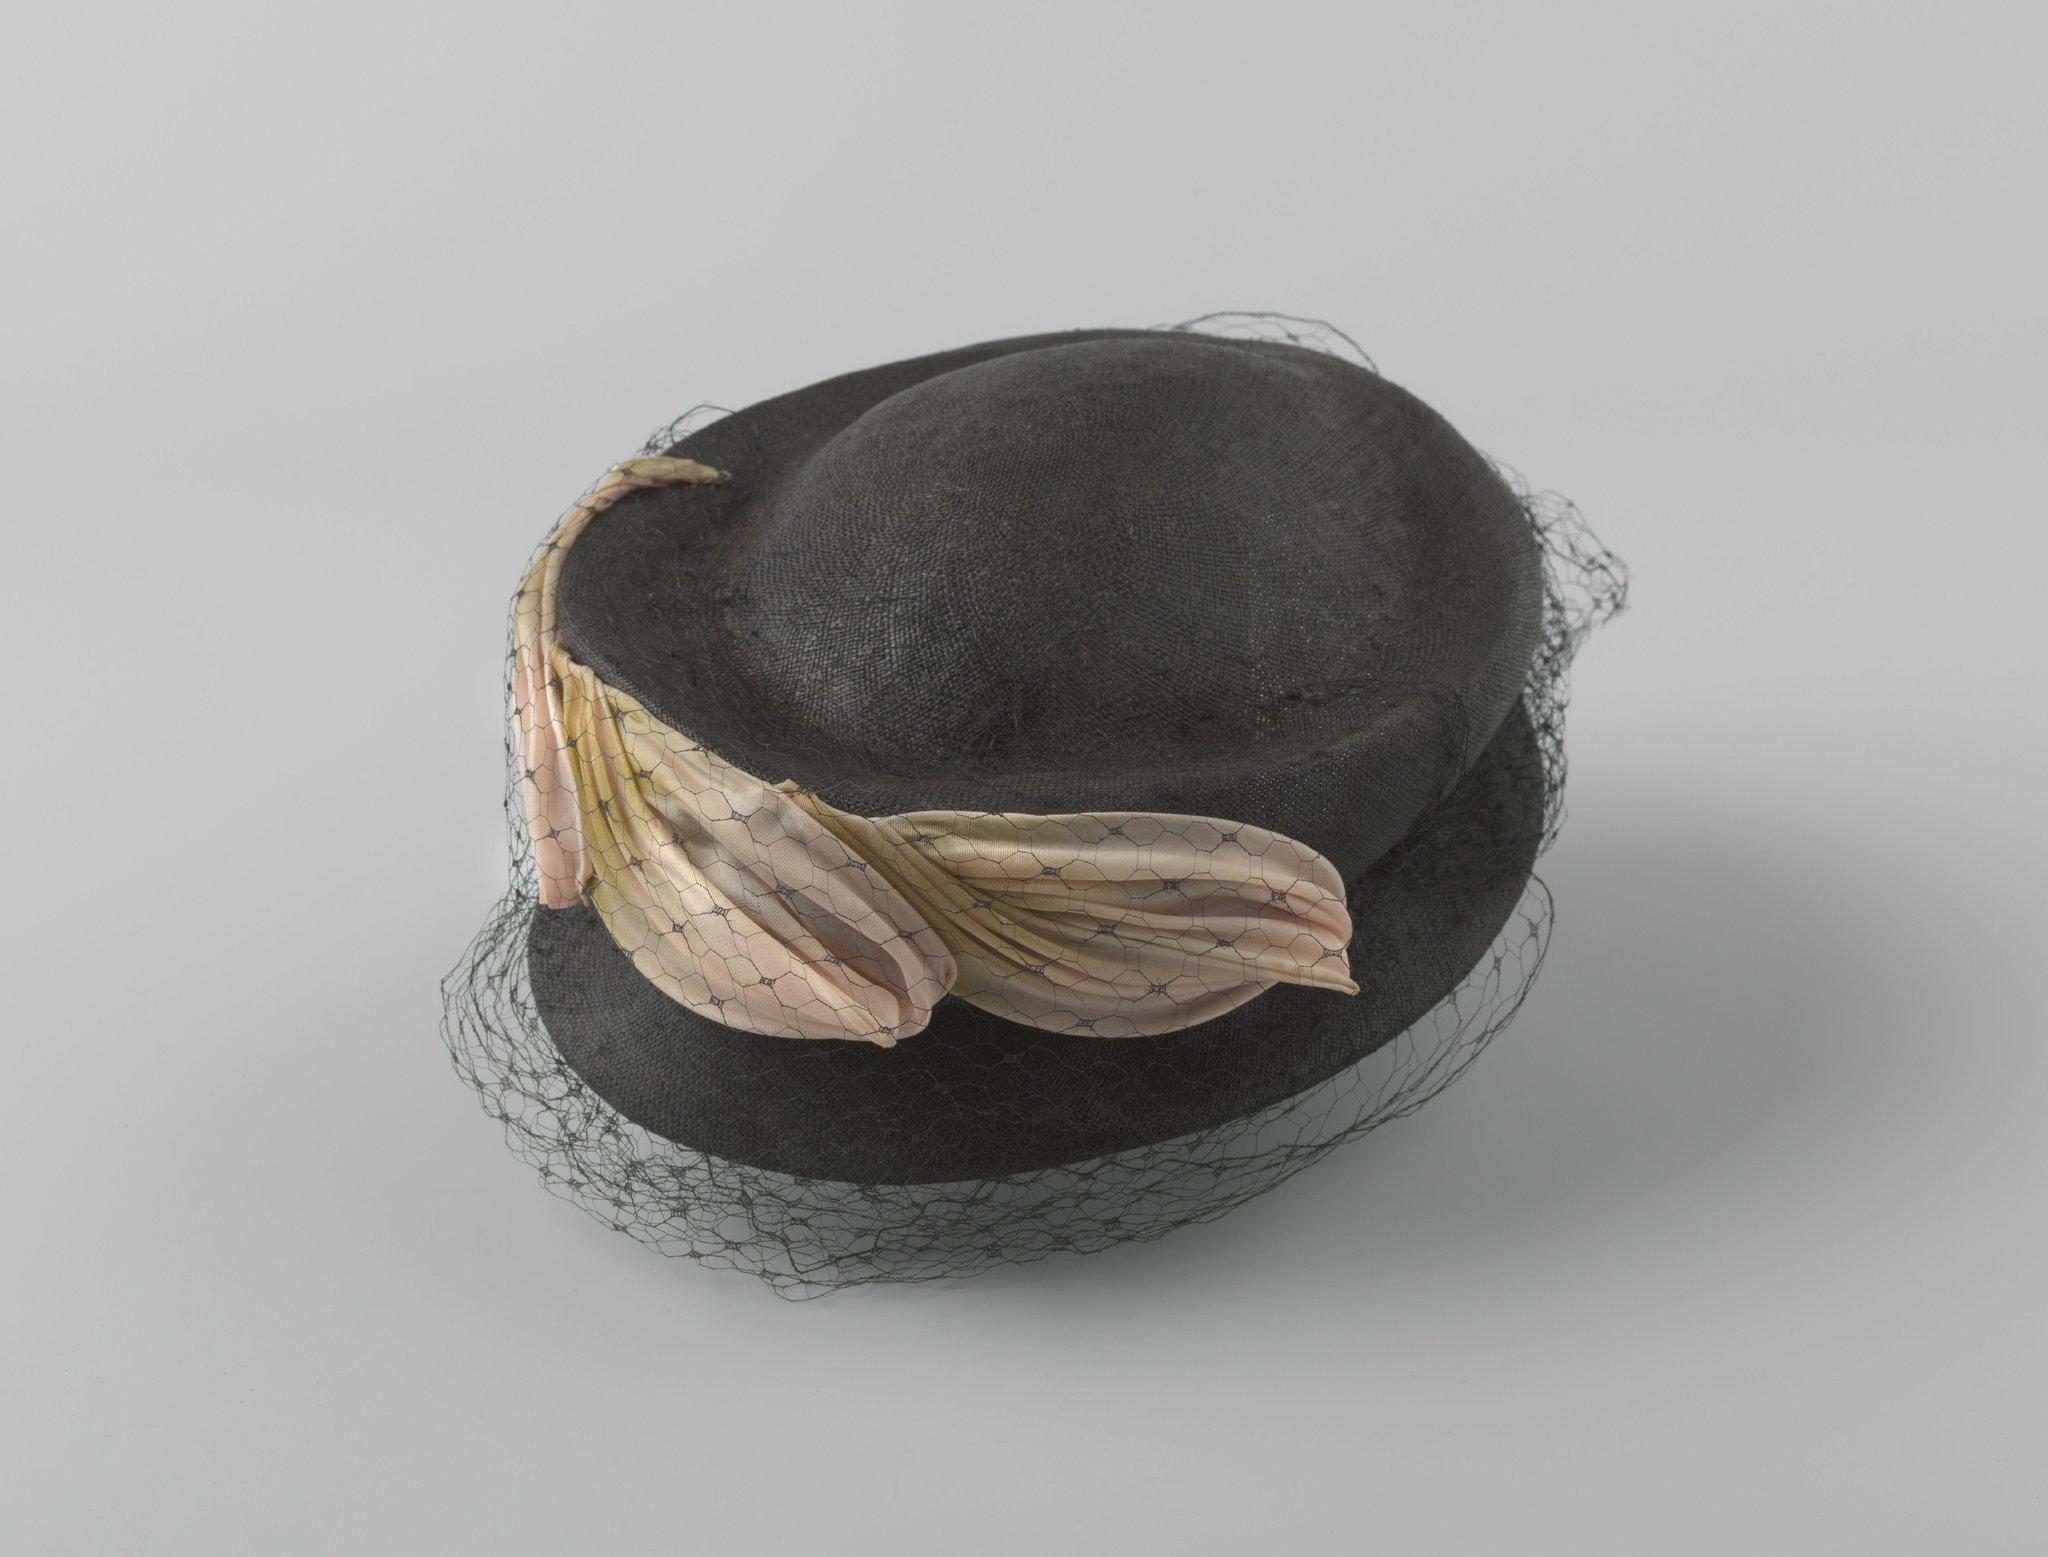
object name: hat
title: Hoed van zwart stro, versierd met drie tulpvormige bloembladeren van rose zijde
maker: Anonymous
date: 1955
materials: silk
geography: paris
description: Hoed van fijn zwart stro. Lage, smalle toque, gerekt cylindrisch. Van voren versierd met drie tulpvormige bloembladeren van roze zijde, vloeiend verlopend in mosgroen. Om de gehele cylinder is een kleine zwarte voile gedrapeerd, die nauwelijks onder de hoed uitkomt, vanachter in een stukje vastgelegd, Adres: Création Paris.